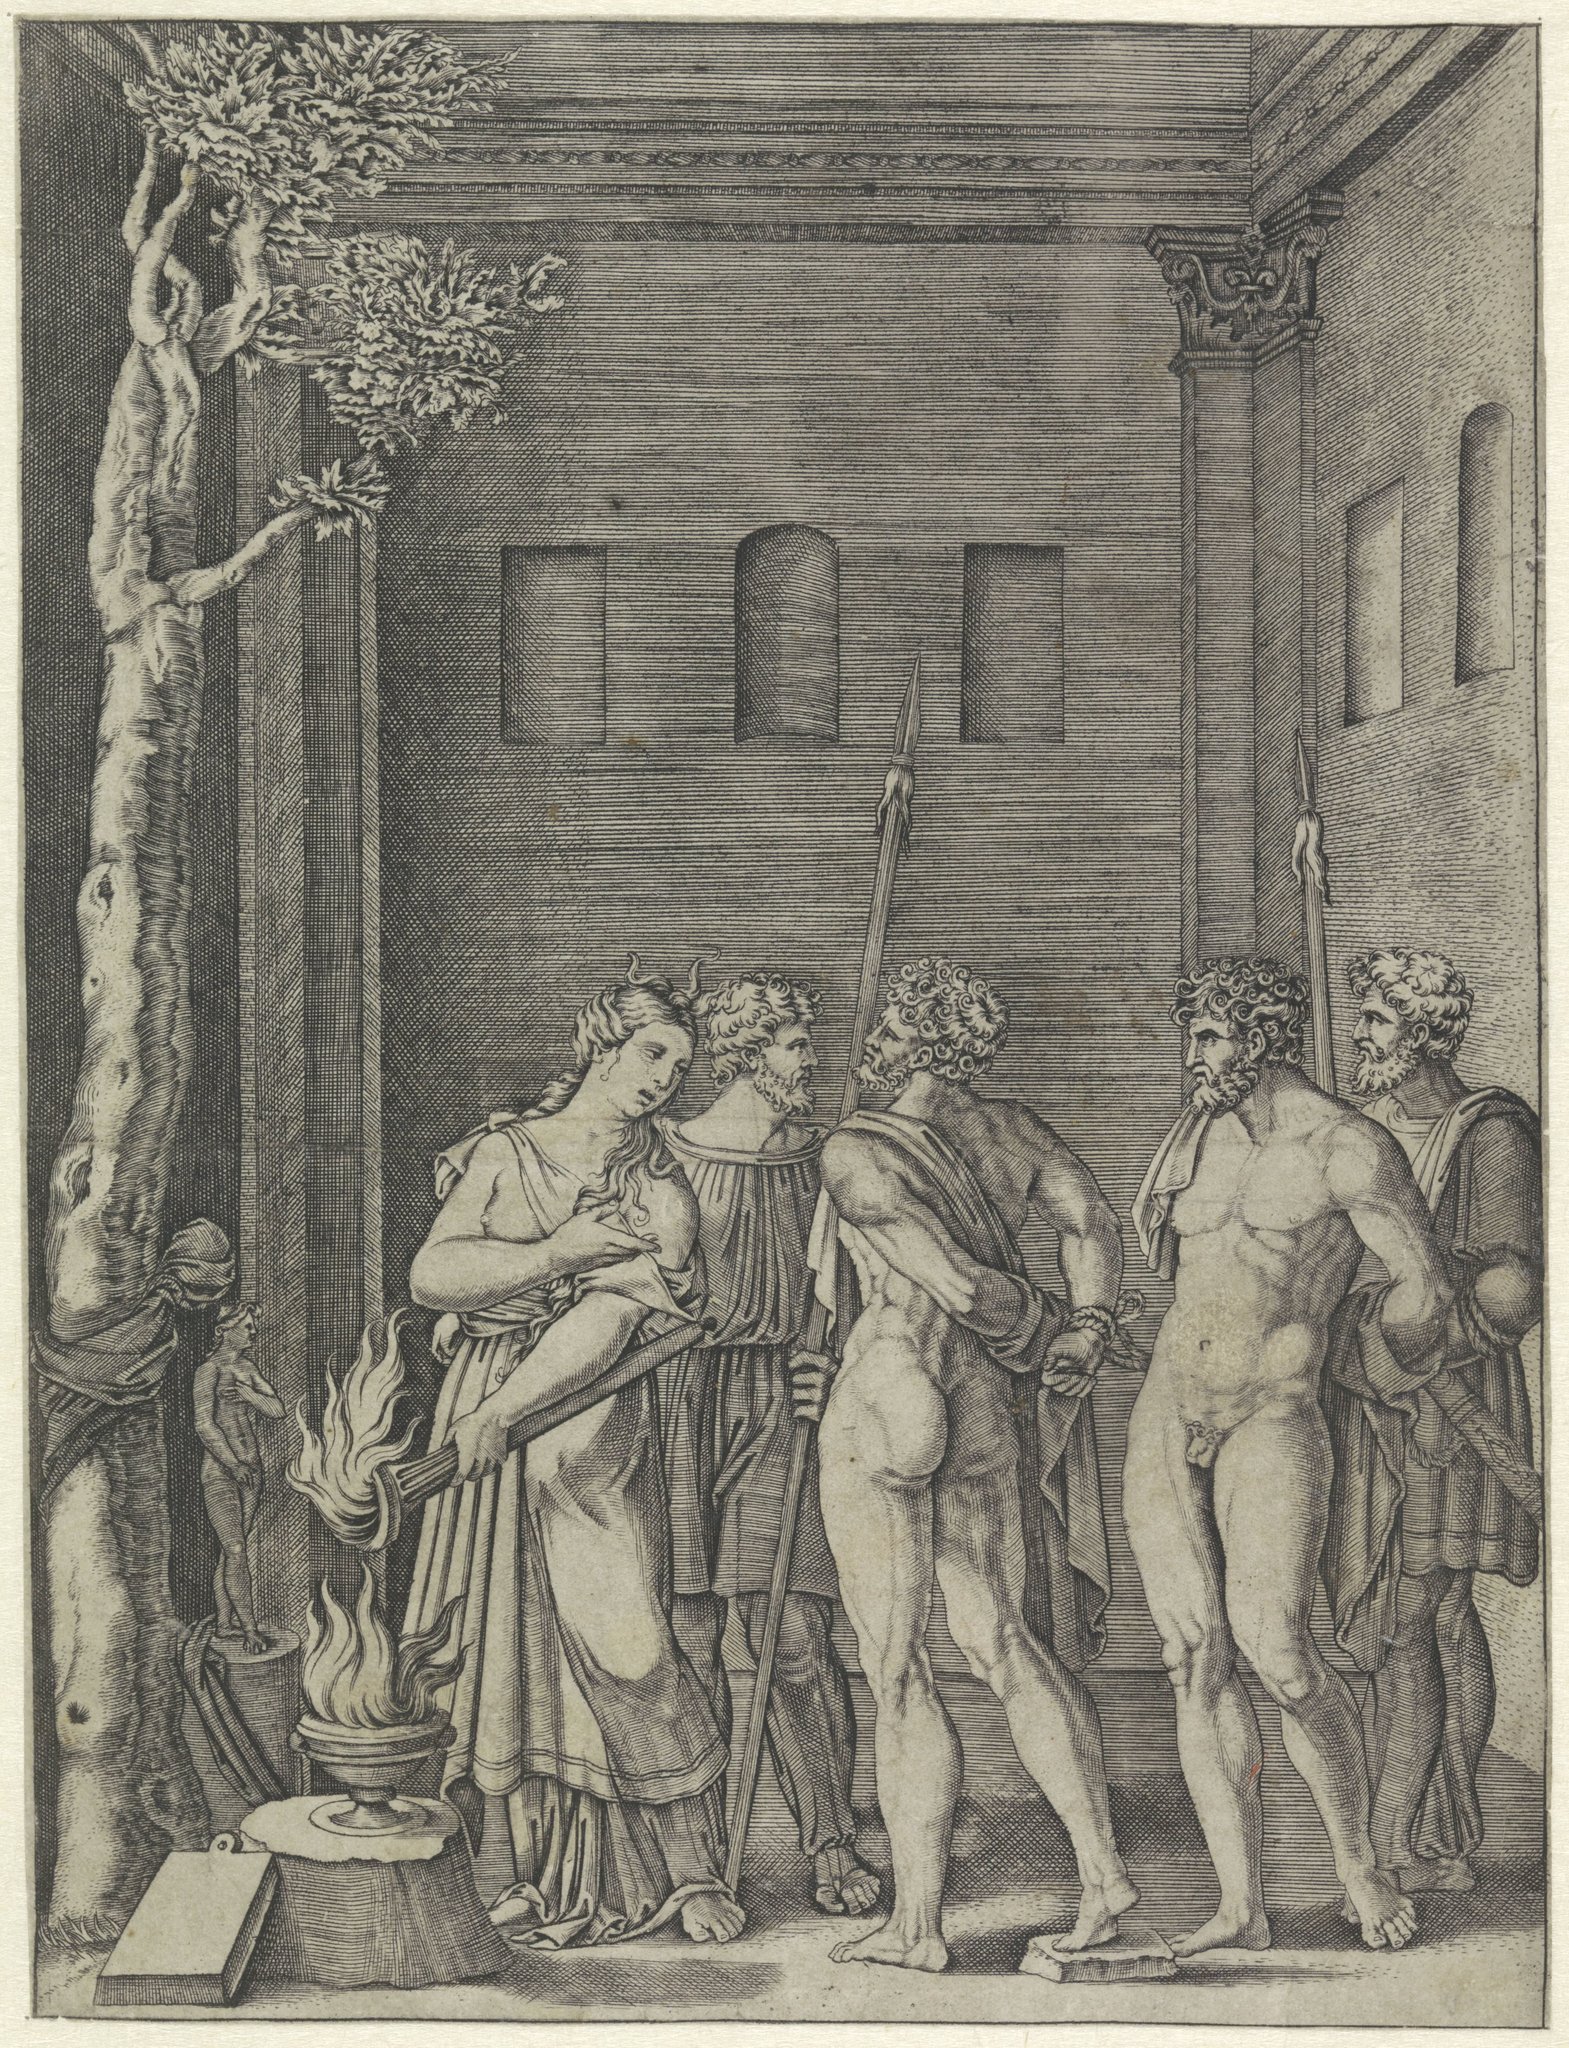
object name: print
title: Iphigenia herkent Orestes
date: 1500-1536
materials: paper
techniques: engraving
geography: italy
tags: iphigenia recognizes her brother orestes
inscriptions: collector's mark: Lugt 240, collector's mark: Lugt 2228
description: Iphigenia, priesteres van Diana, herkent haar broer Orestes en zijn metgezel Pylades. De mannen zijn geboeid om aan Diana te worden geofferd.